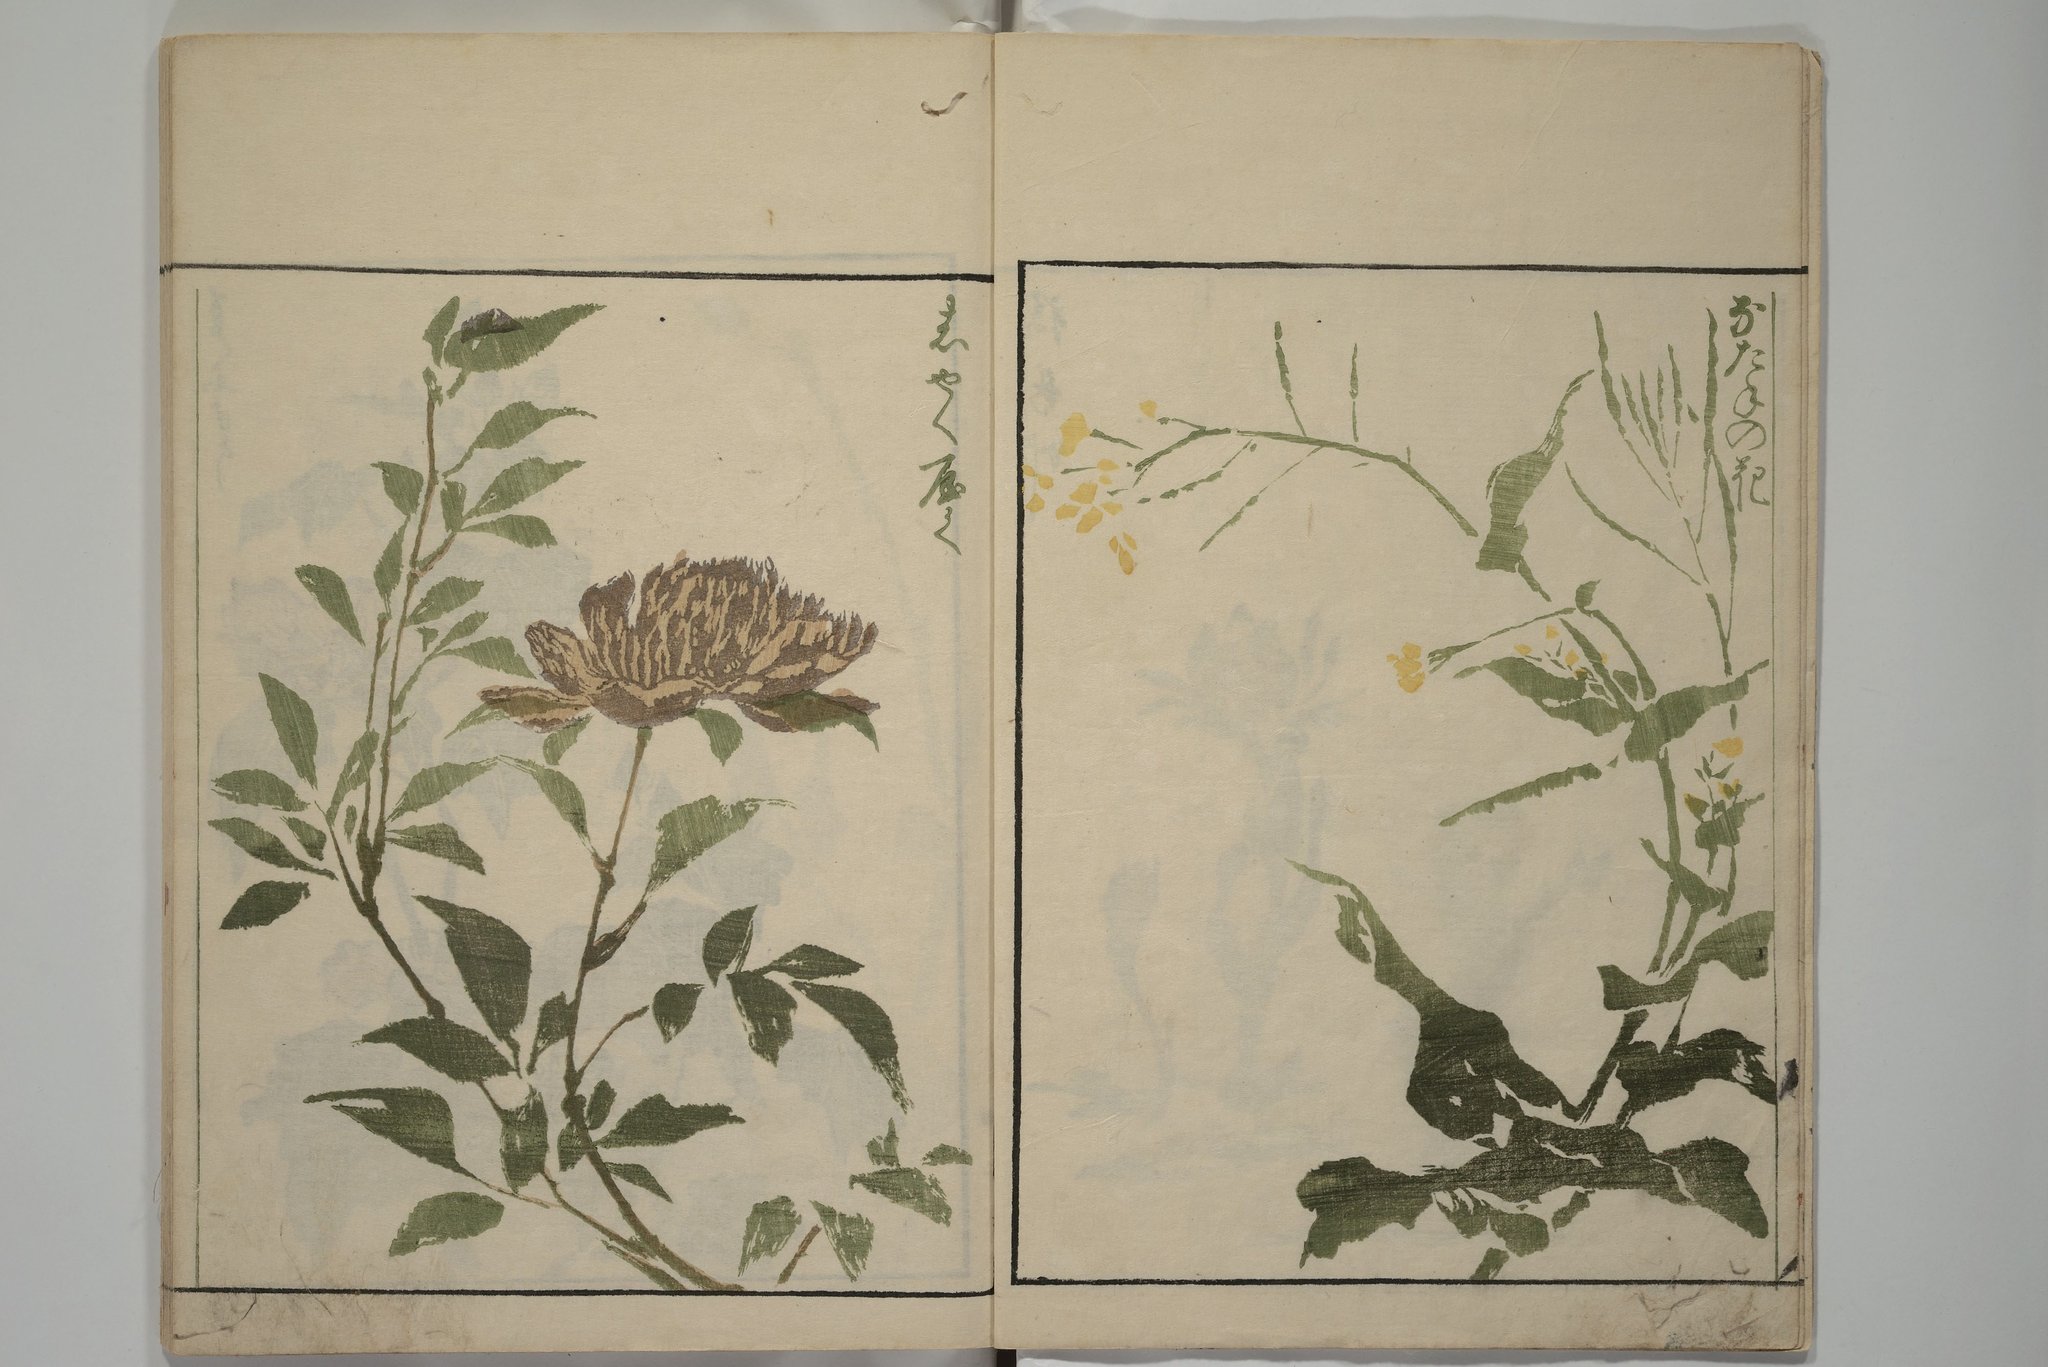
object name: illustrated book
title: How to Draw Plants and Flowers Simply (Sōka ryakugashiki) 草花略画式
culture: japanese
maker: kuwagata keisai 鍬形蕙斎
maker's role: artist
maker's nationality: japanese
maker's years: 1764-1824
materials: ink, paper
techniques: woodblock print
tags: flowers